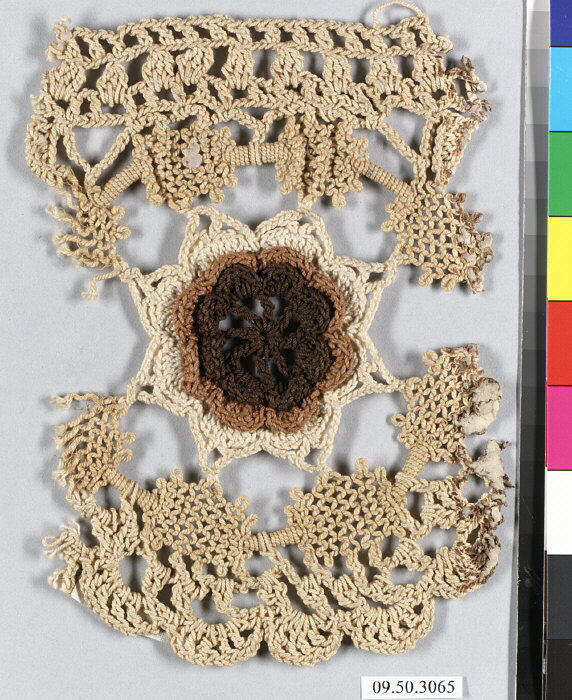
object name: sample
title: Crochet Work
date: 1801-1900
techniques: crochet